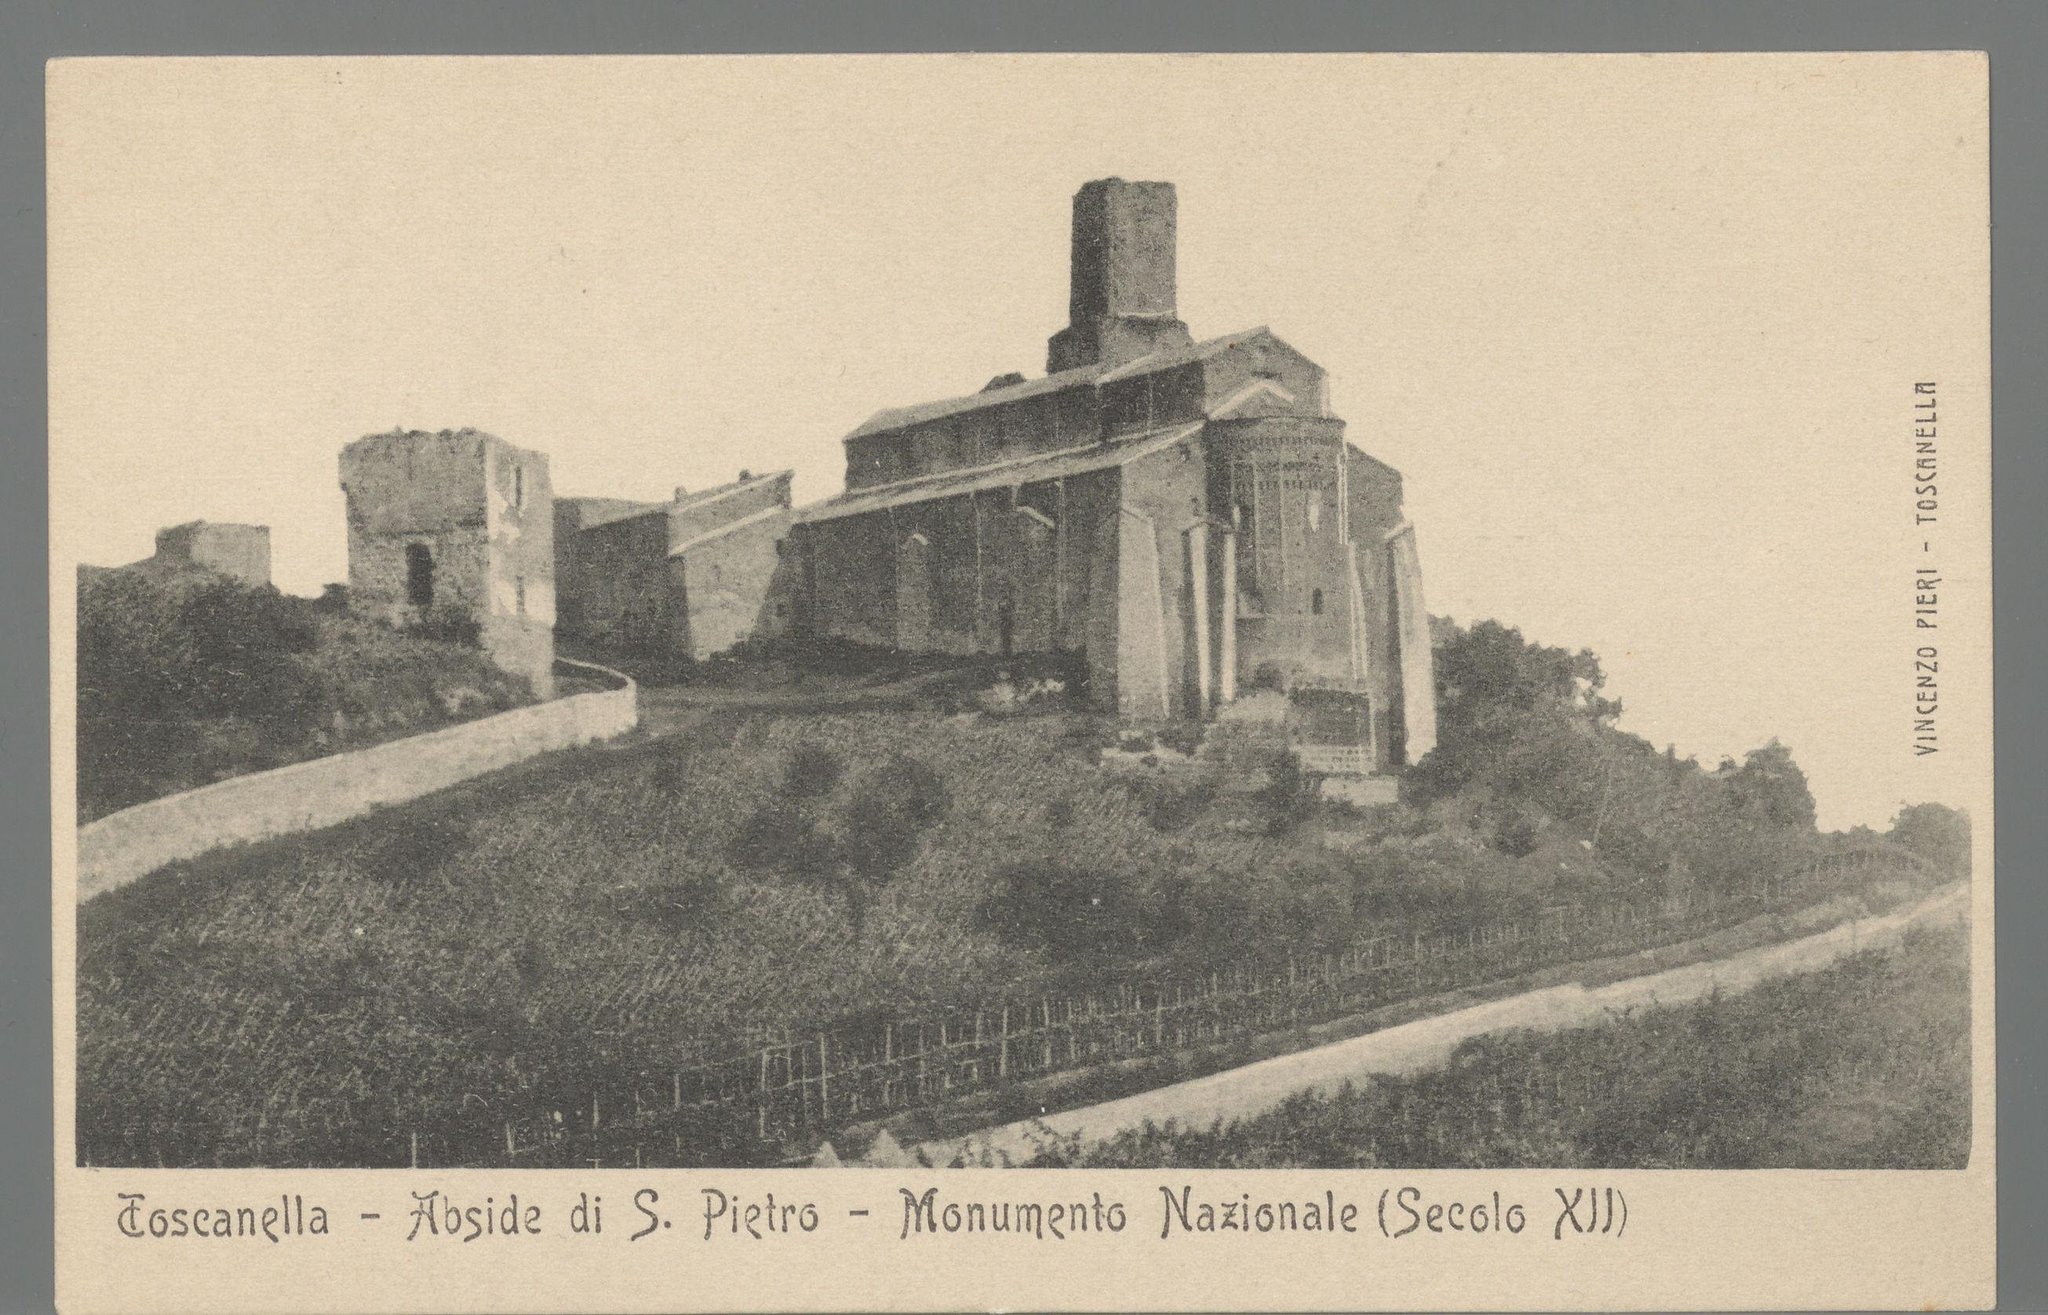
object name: ansichtkaart, prentbriefkaart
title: Toscanella. Abside di S. Pietro. Monumento Nazionale (Secolo XII)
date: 1889-1906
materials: cardboard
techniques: photograph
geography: tuscania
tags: church (exterior)